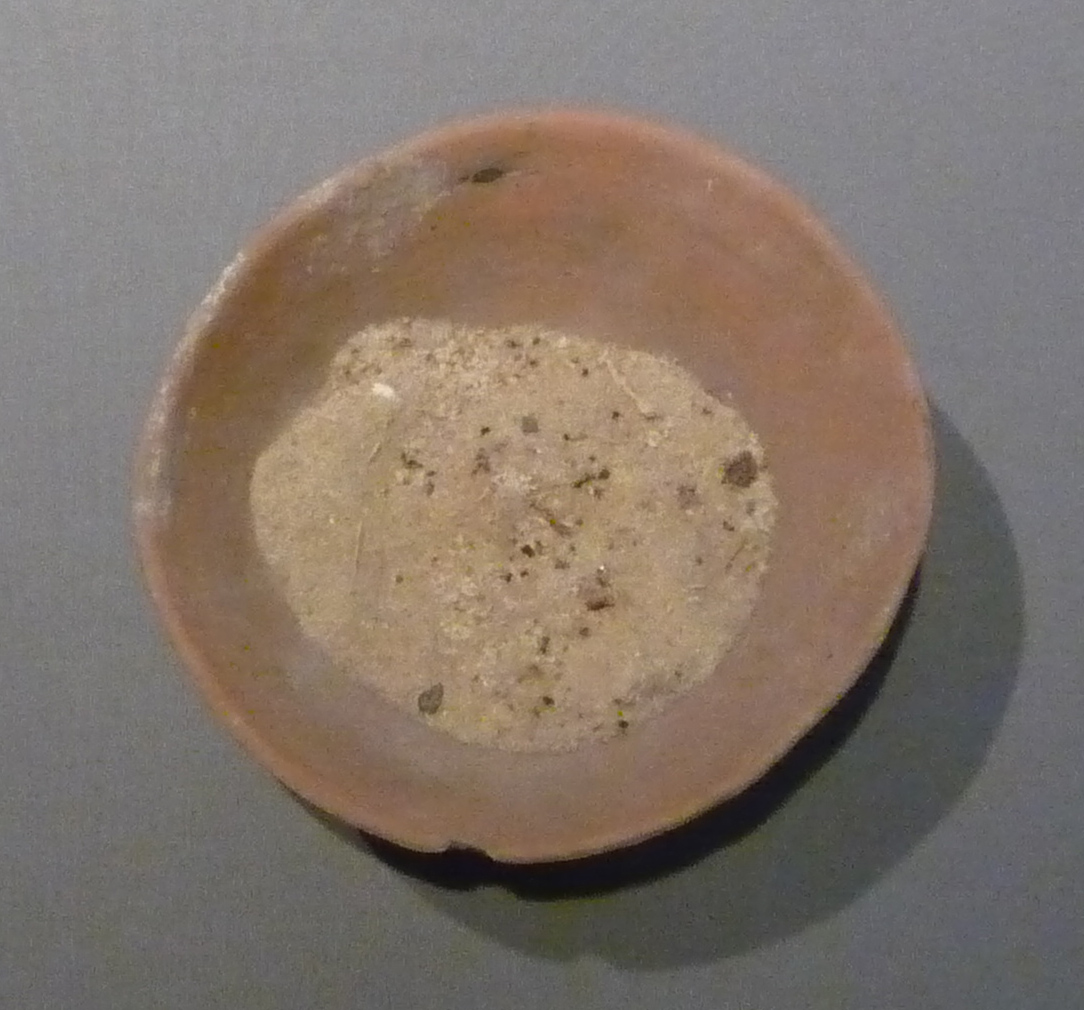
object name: bowl, fig, foundation deposit, hatshepsut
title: Bowl of Sand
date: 1479-1458 BCE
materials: pottery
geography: egypt